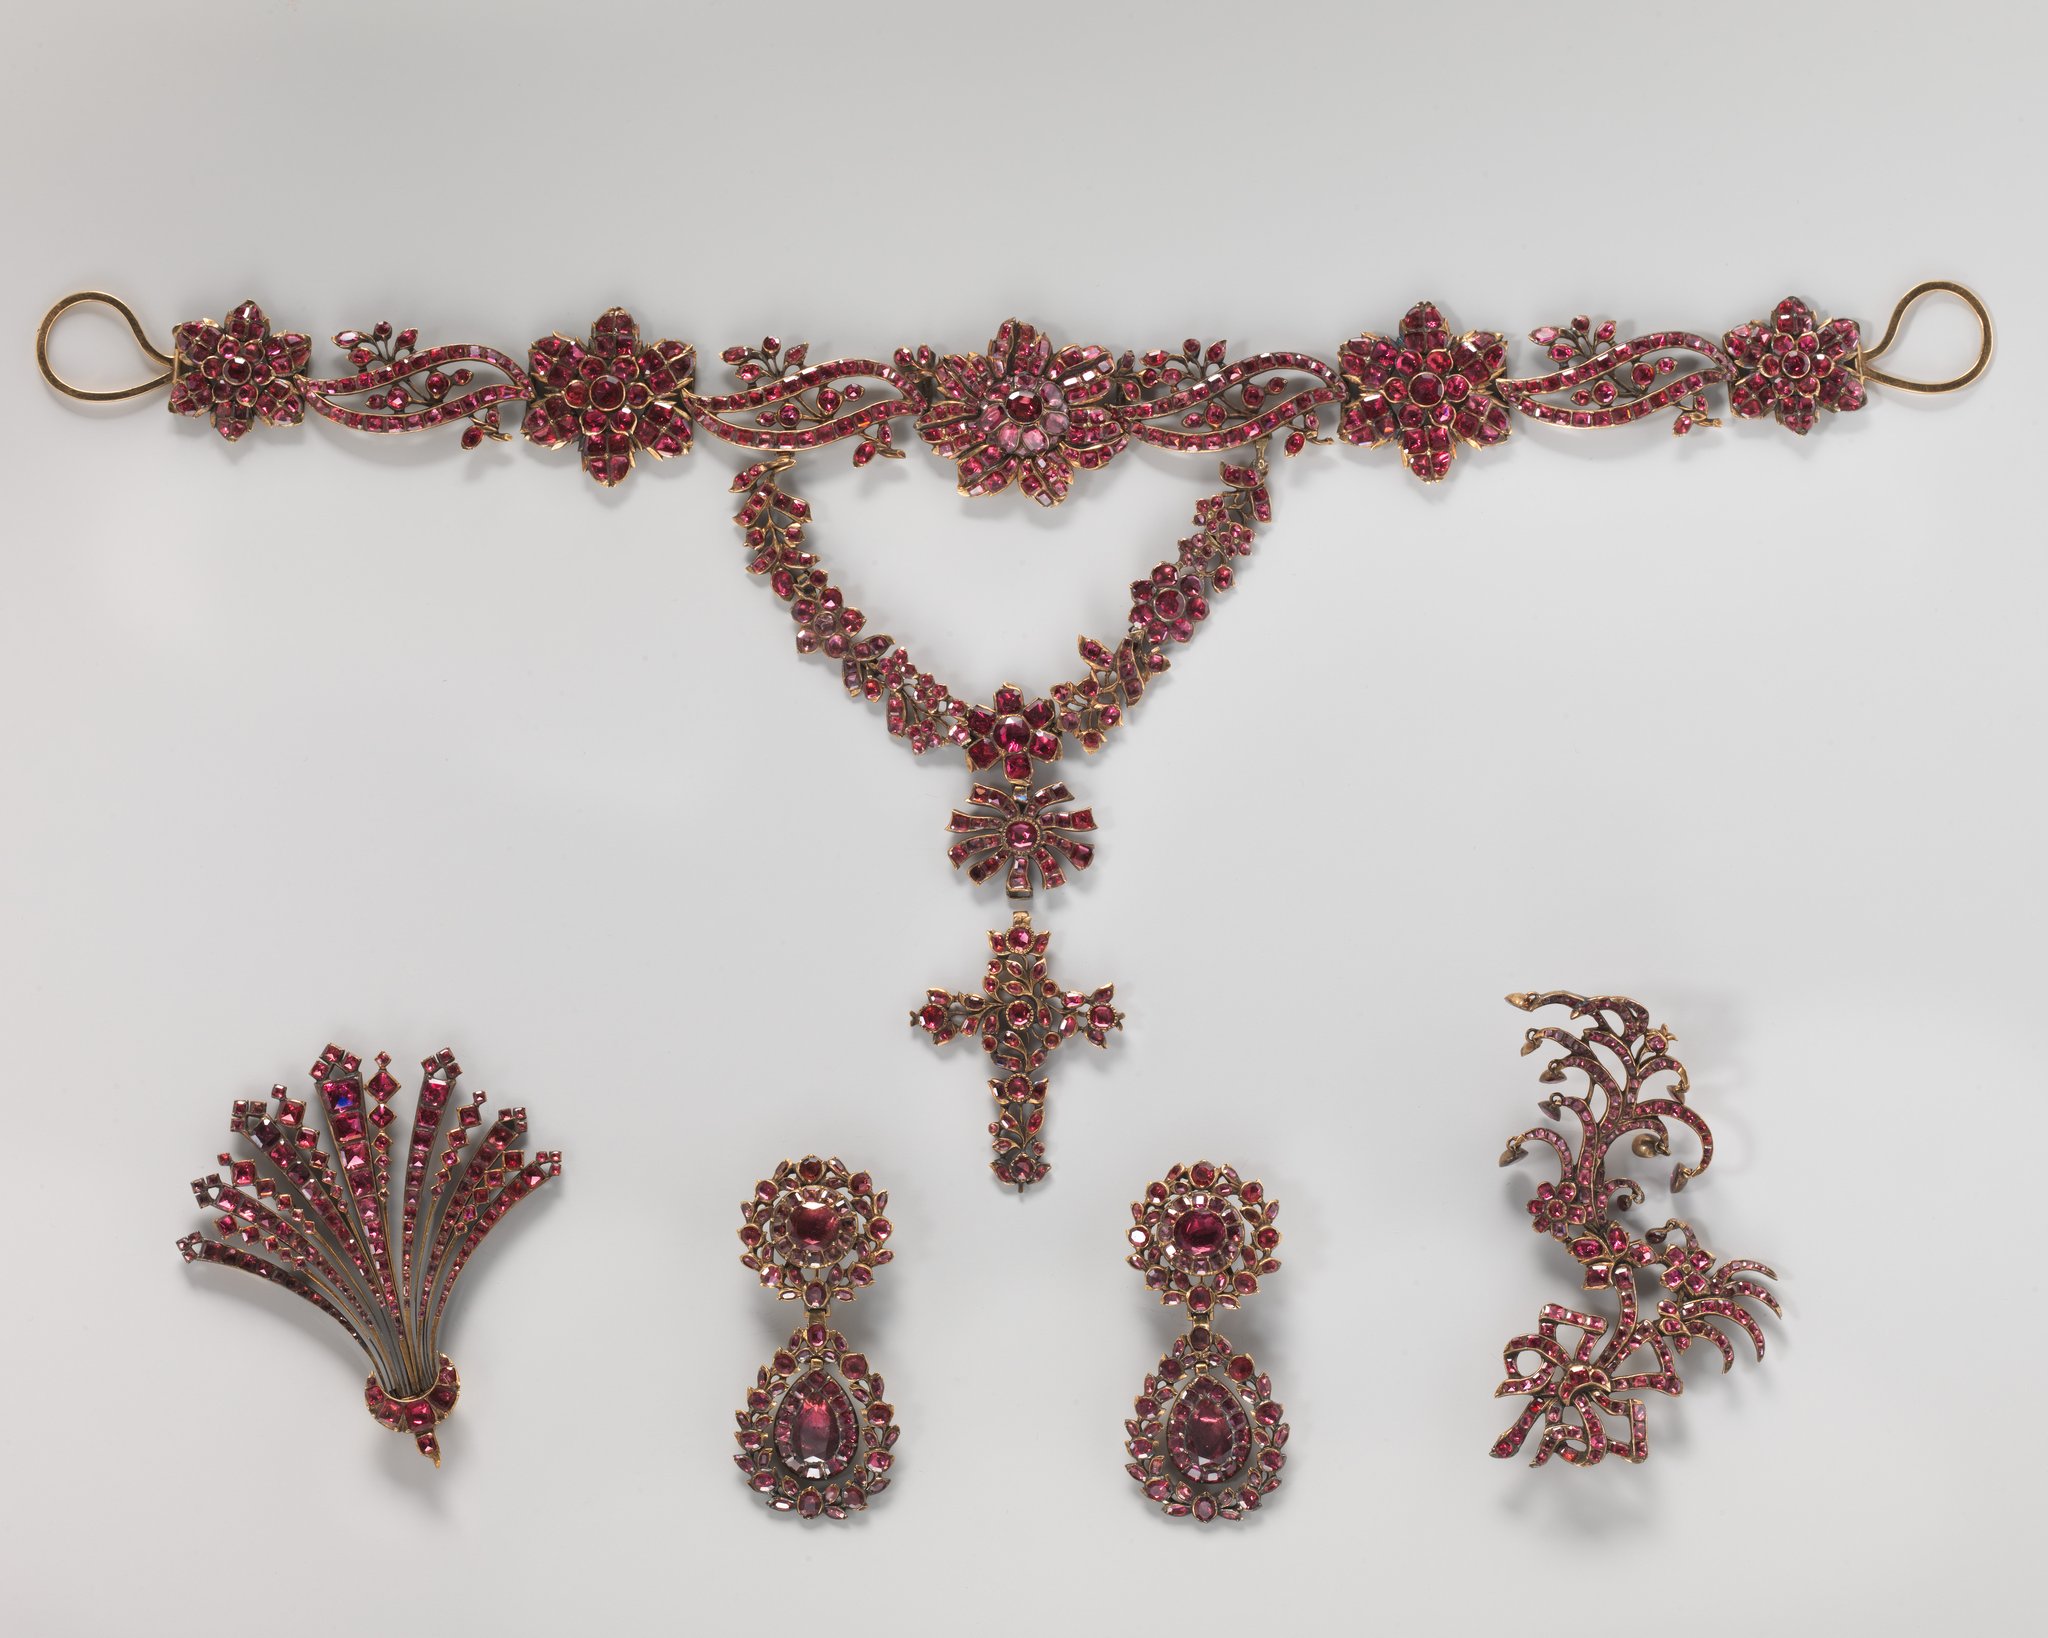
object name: parure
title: Five-piece parure in original case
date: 1751-1775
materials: gemstone, gold, silk, wood